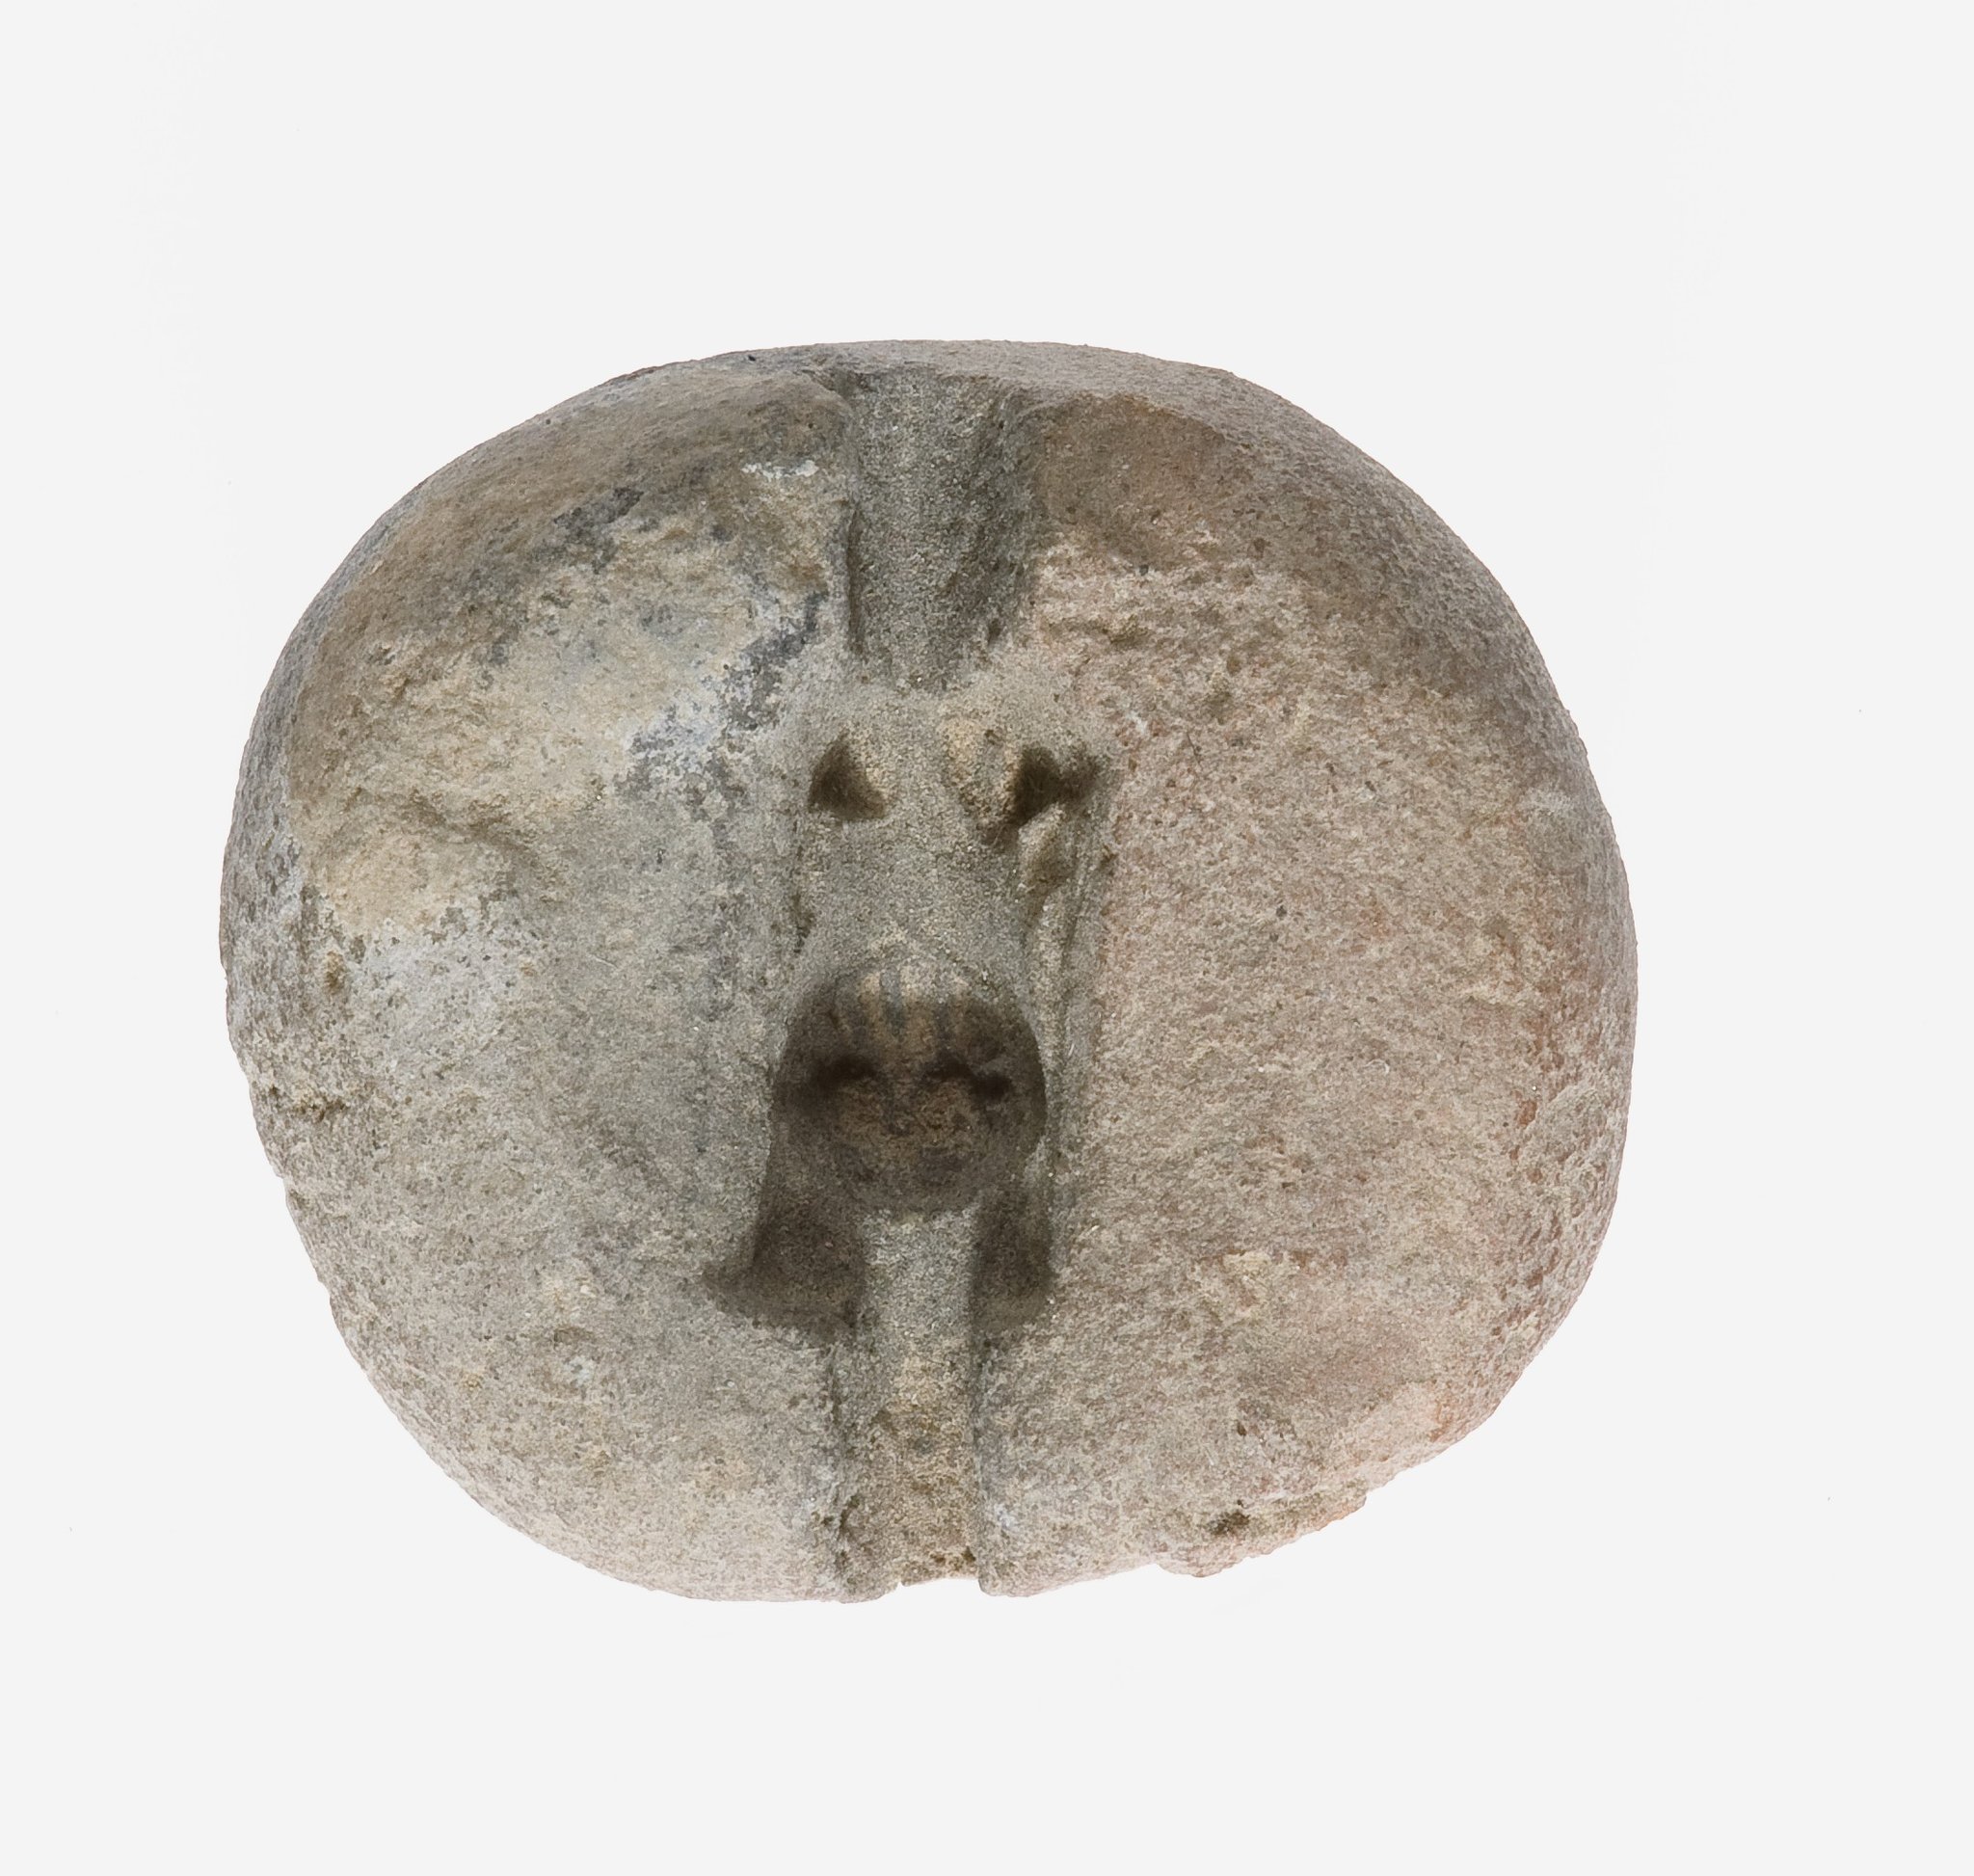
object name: mold, amulet, lion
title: Mold for a Lion Amulet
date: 1390-1352 BCE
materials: pottery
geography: egypt